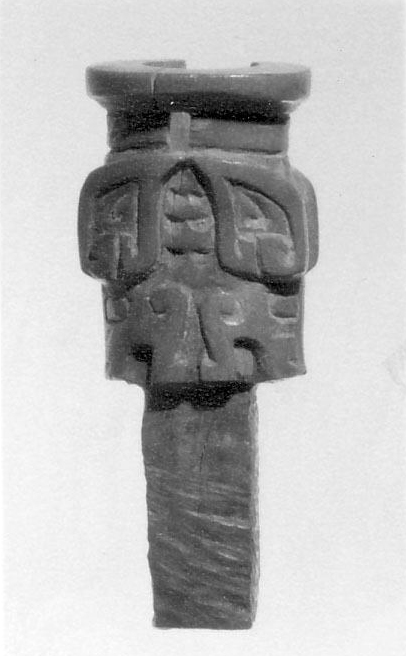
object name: finial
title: Socketed Finial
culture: chinese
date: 1300-1001 BCE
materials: bone, ivory